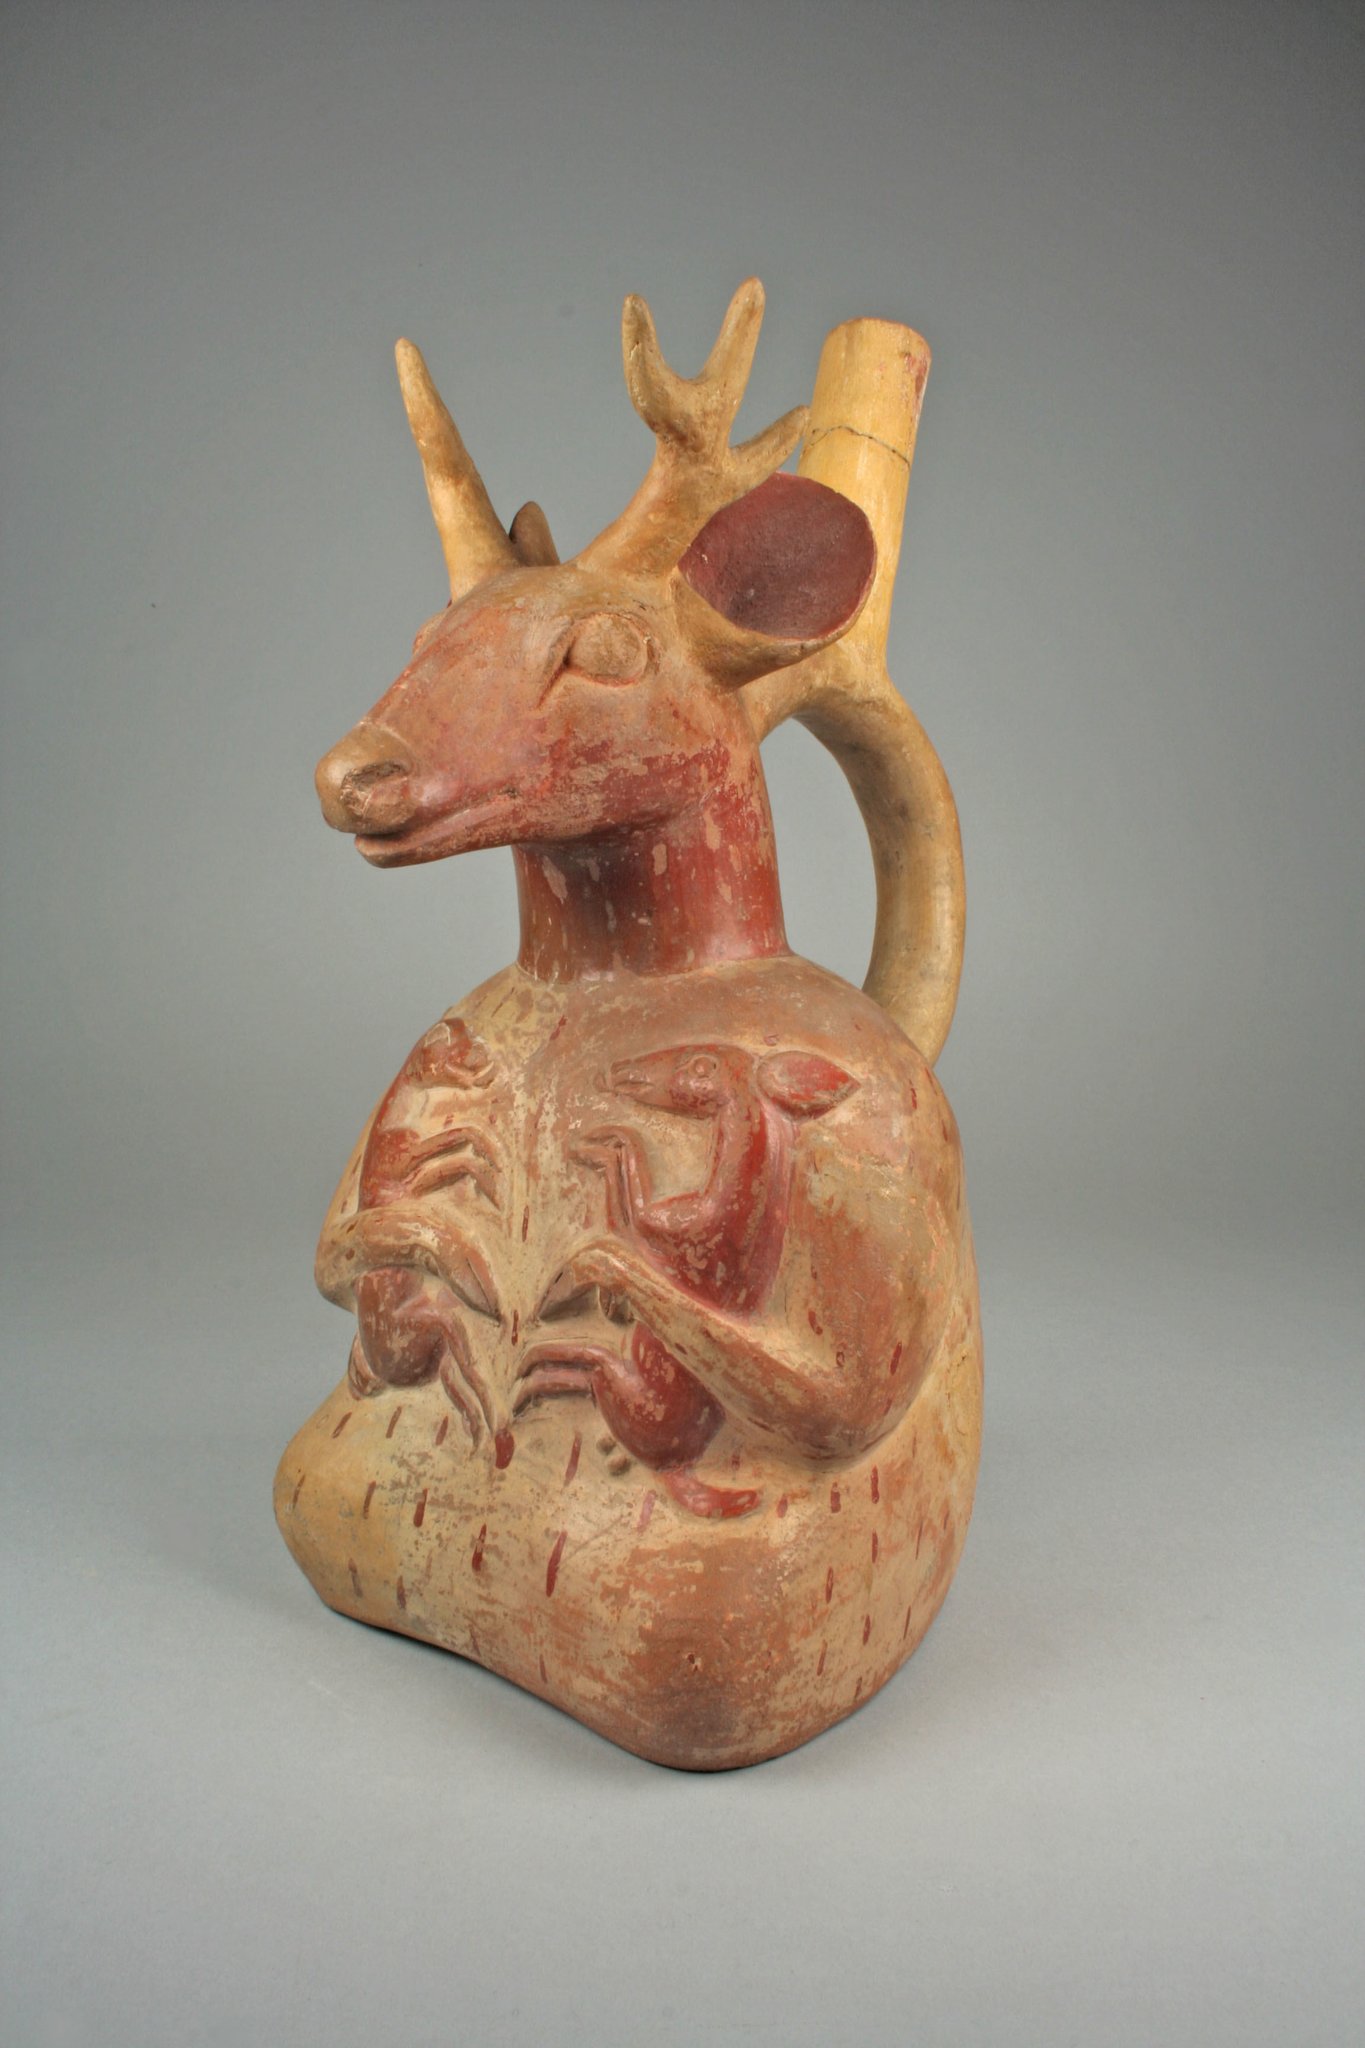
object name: bottle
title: Stirrup-spout bottle with deer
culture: moche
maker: moche artist(s)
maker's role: artist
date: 500-800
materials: ceramic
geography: peru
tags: deer